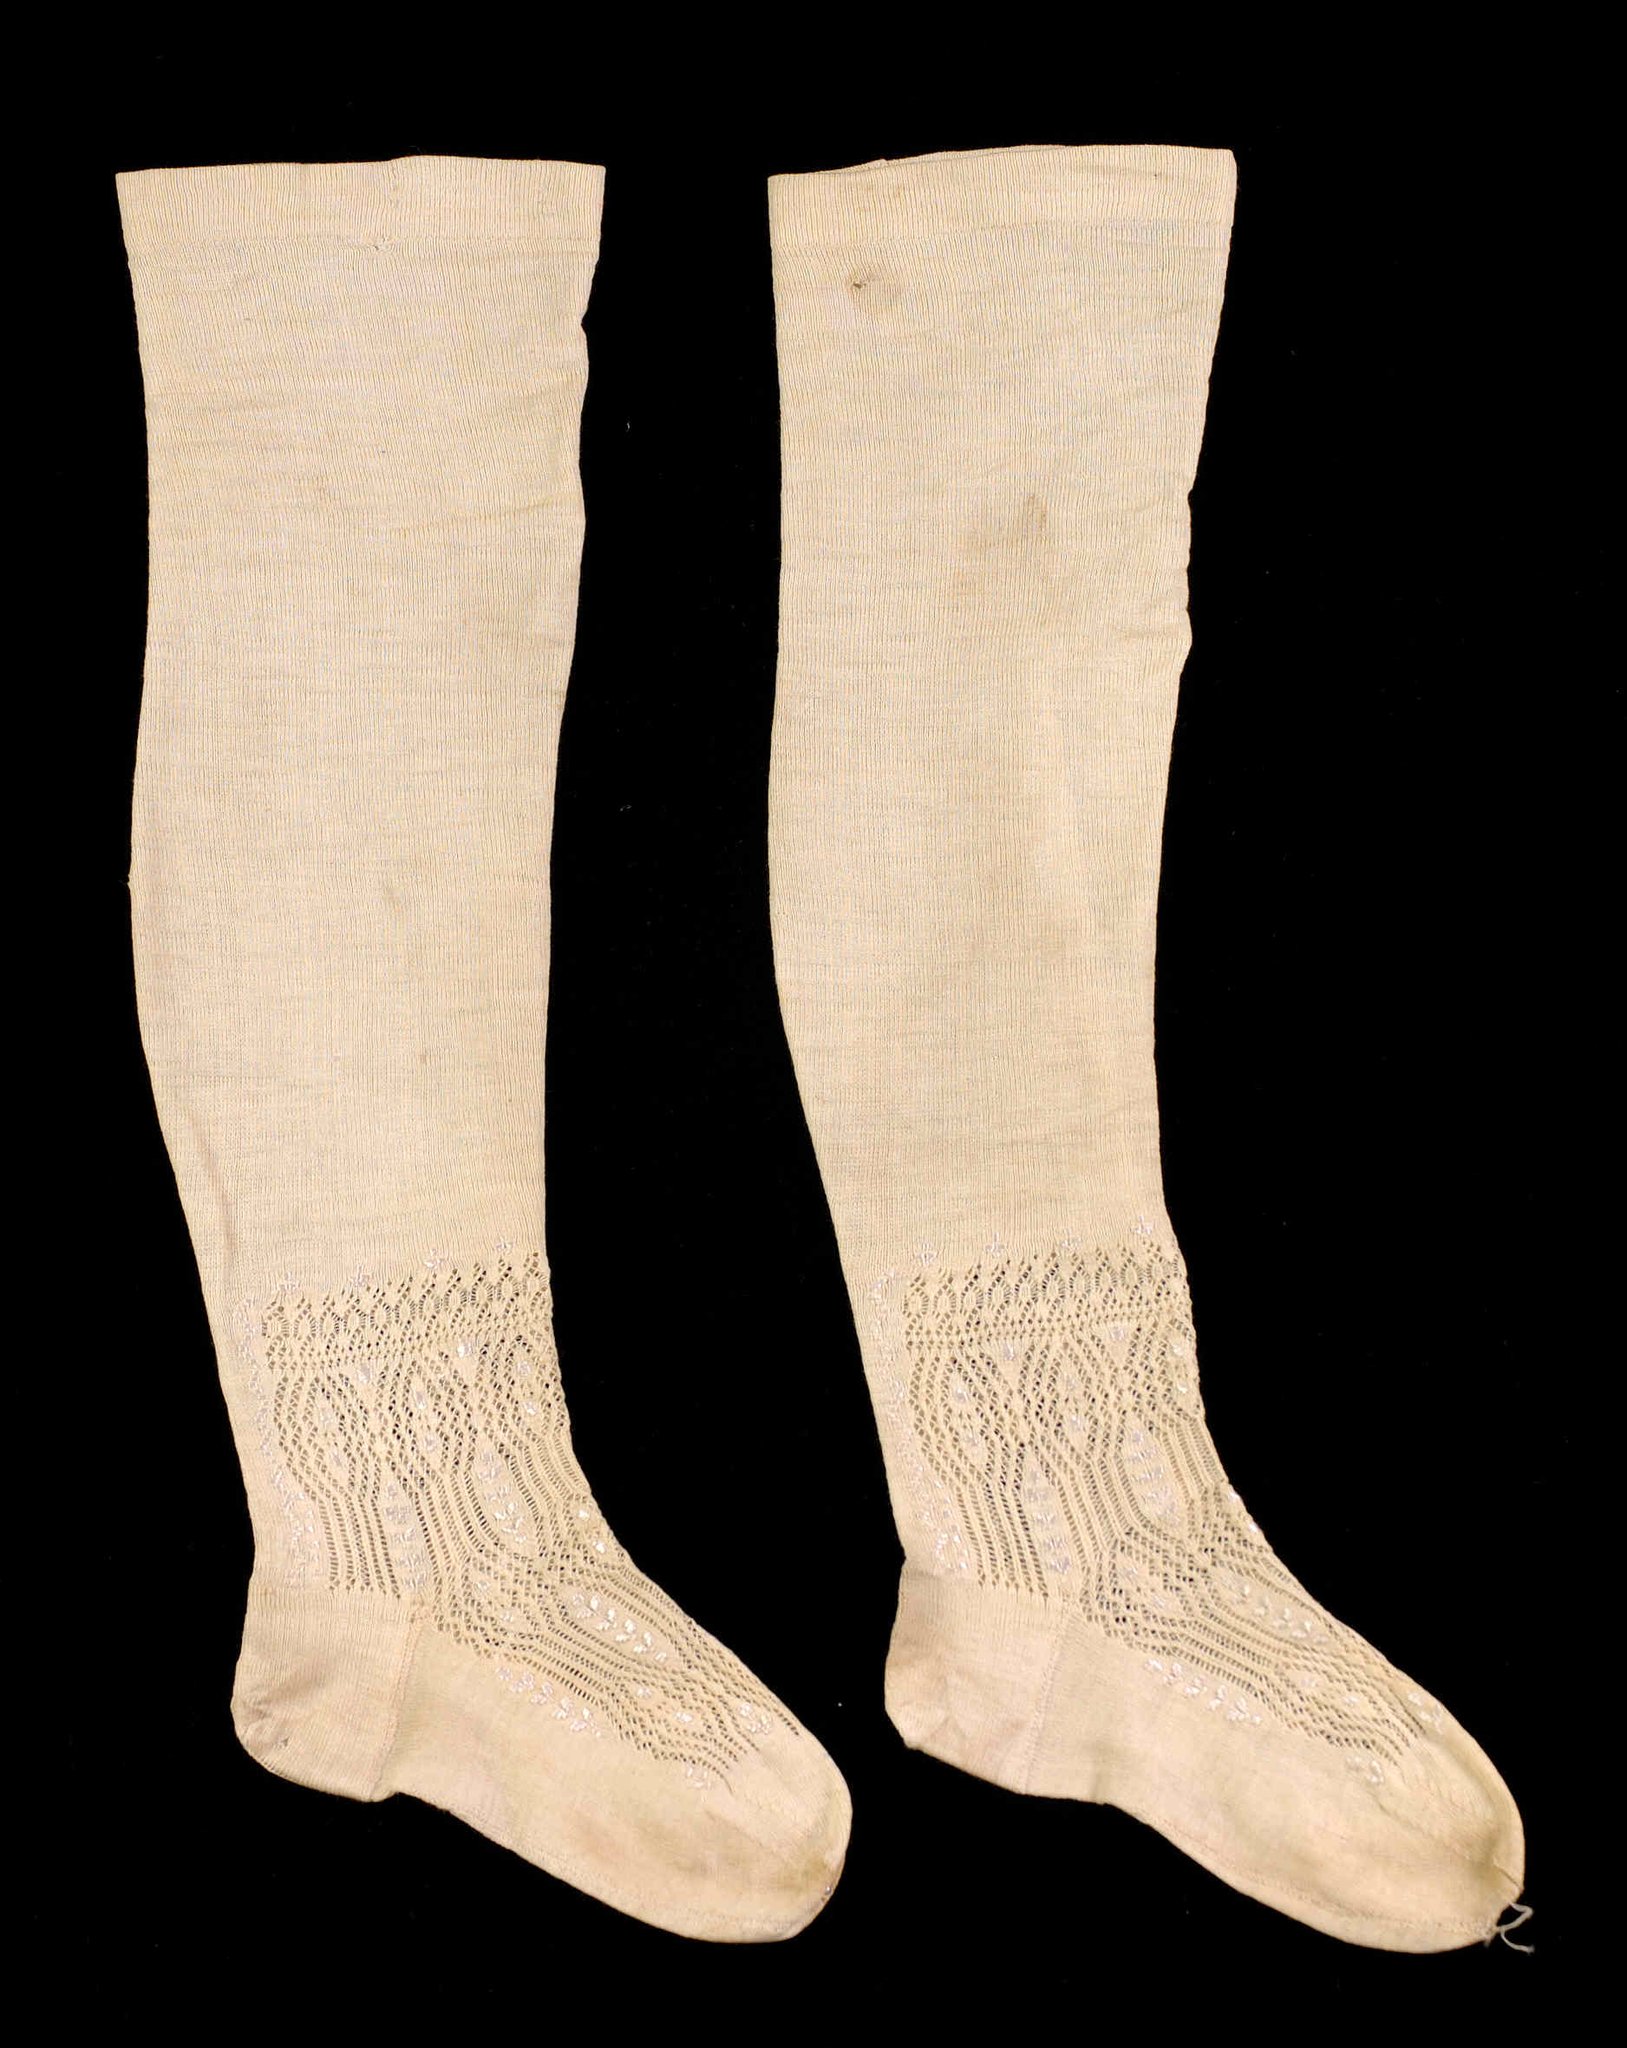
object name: stocking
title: Stockings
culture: american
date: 1860-1870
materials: cotton